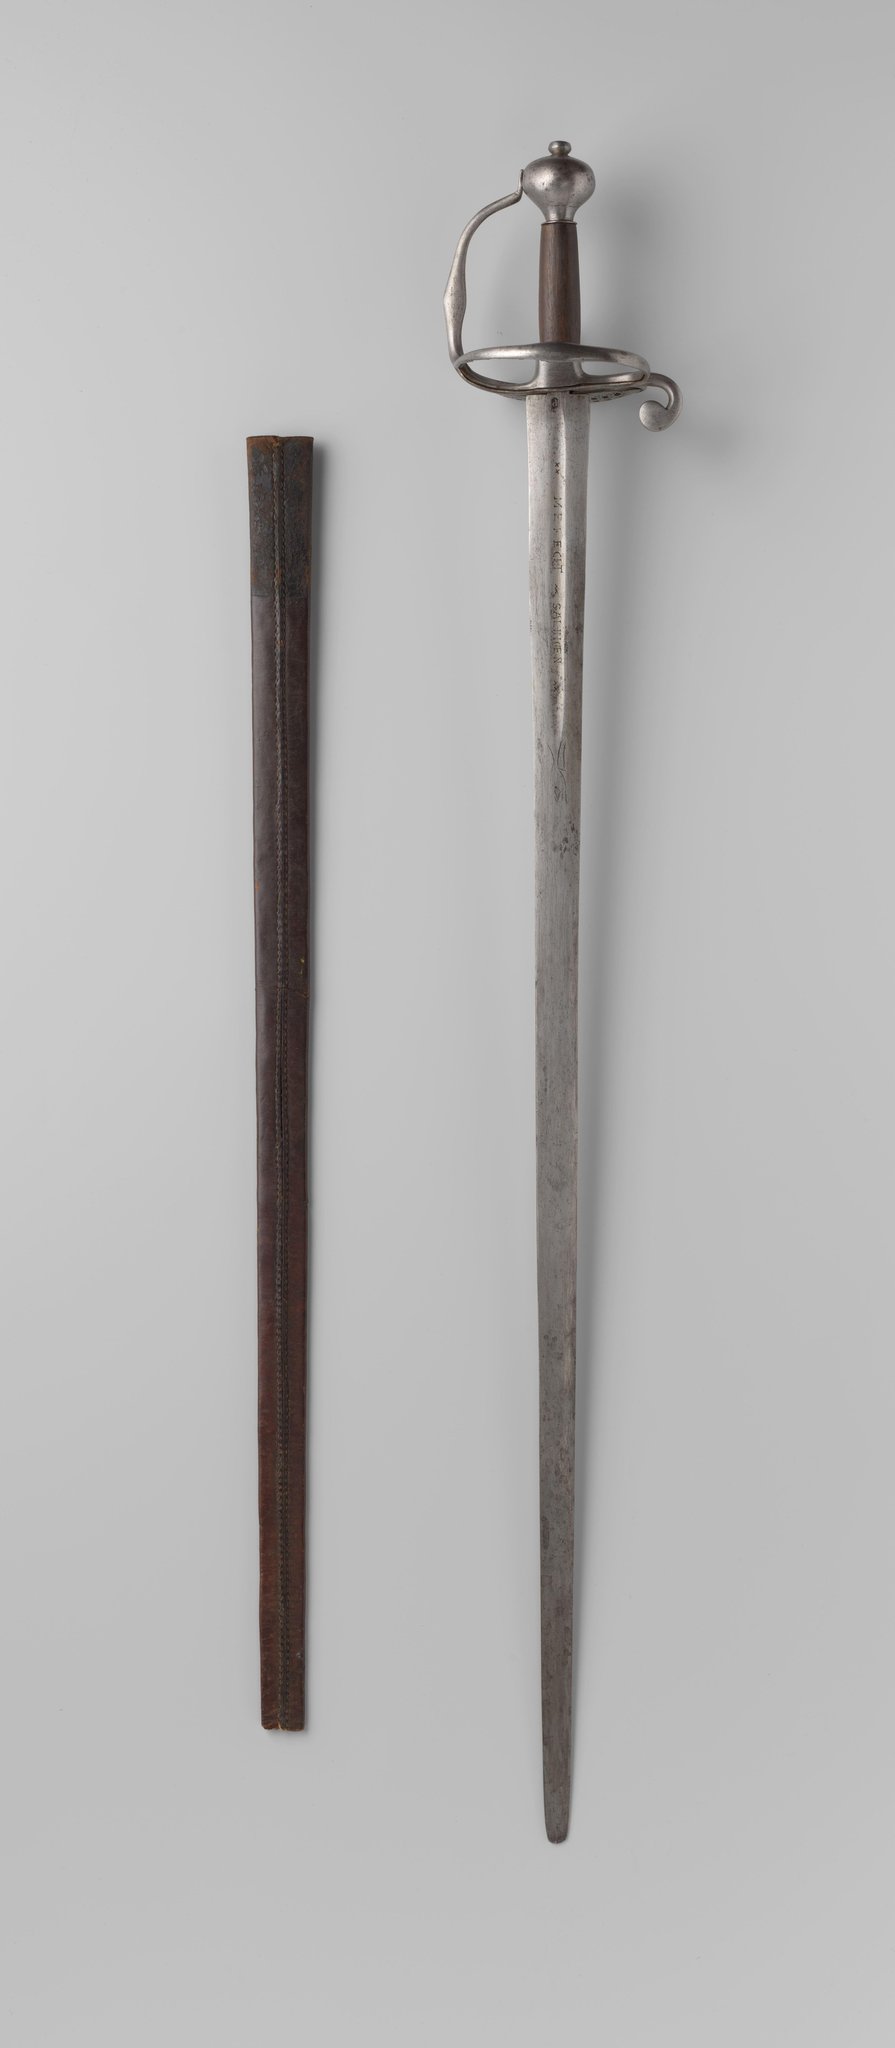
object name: sword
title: Ridderdegen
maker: hans von salingen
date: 1609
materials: iron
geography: hamburg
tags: netherlands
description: Ridderdegen, wolfskling (zo genoemd naar het merk 1414) met opschrift me fecit Salingen.